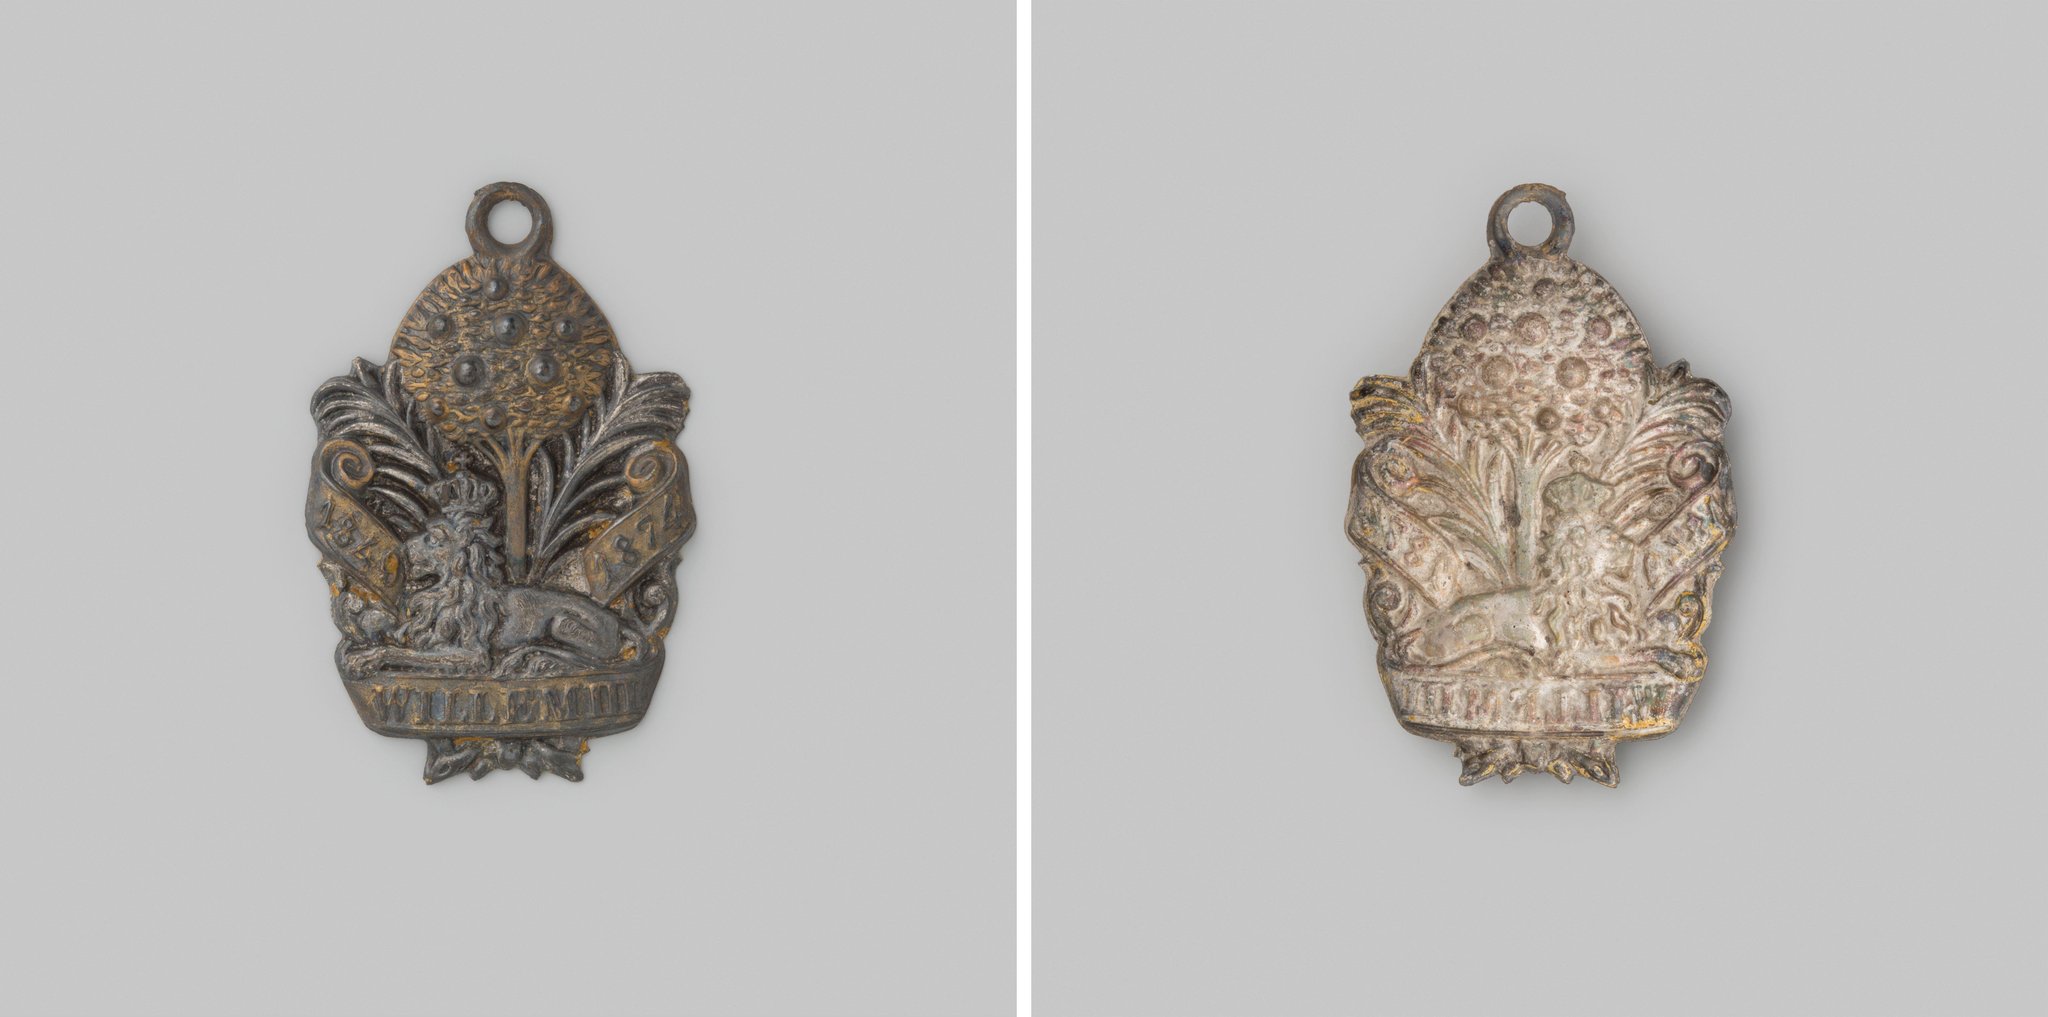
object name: history medal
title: Vijfentwintigjarig regeringsjubileum van Koning Willem III 1874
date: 1874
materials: silver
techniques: pressing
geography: voorschoten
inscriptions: inscription: ‘1849 - WILLEM III - 1874’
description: Deels verguld draagteken in de vorm van een oranjeboom waarvoor een gekroonde leeuw tussen twee palmtakken en een tekstlint.